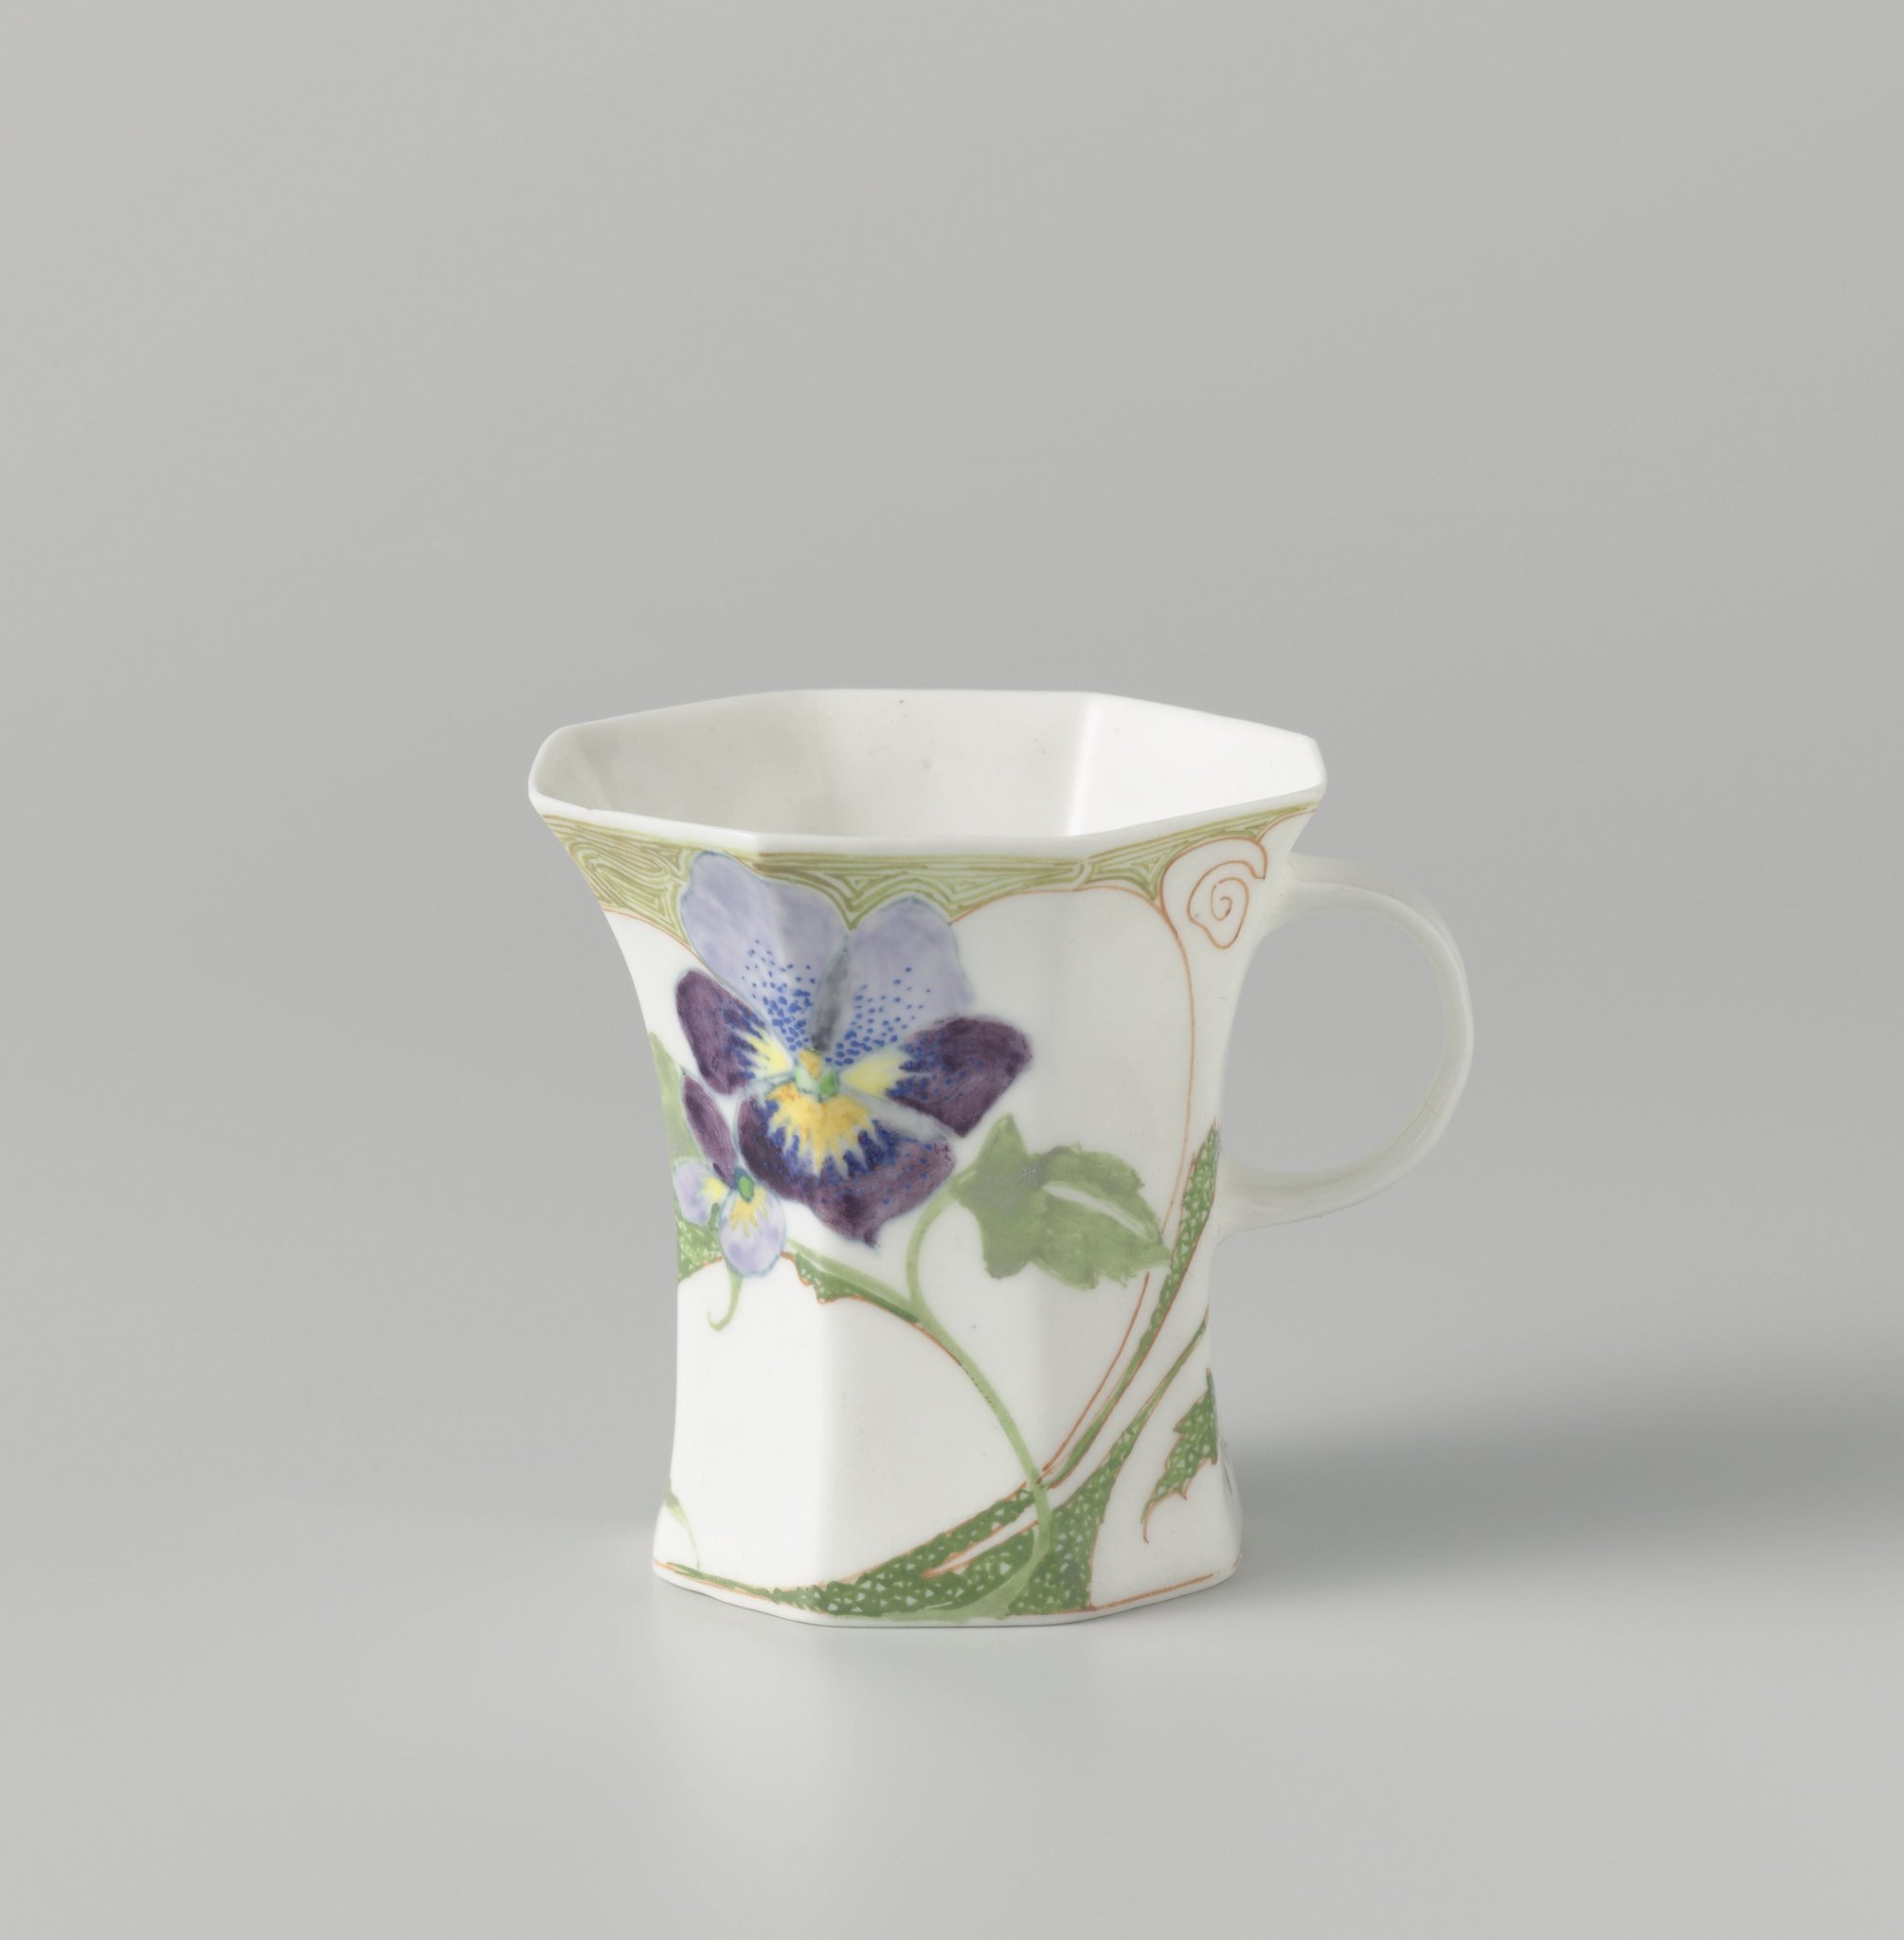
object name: cup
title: Kop, deel van een servies, beschilderd met violen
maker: c.w.j. t hart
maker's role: plateelschilder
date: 1913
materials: porcelain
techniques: painted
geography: the hague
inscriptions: mark: ‘kroon, Rozenburg, ooievaar, den Haag (boven elkaar); links het merk voor 1913, rechts het werkordernummer 332 (op een kop 333); onder het schildersmerk van C.W.J. 't Hart.’